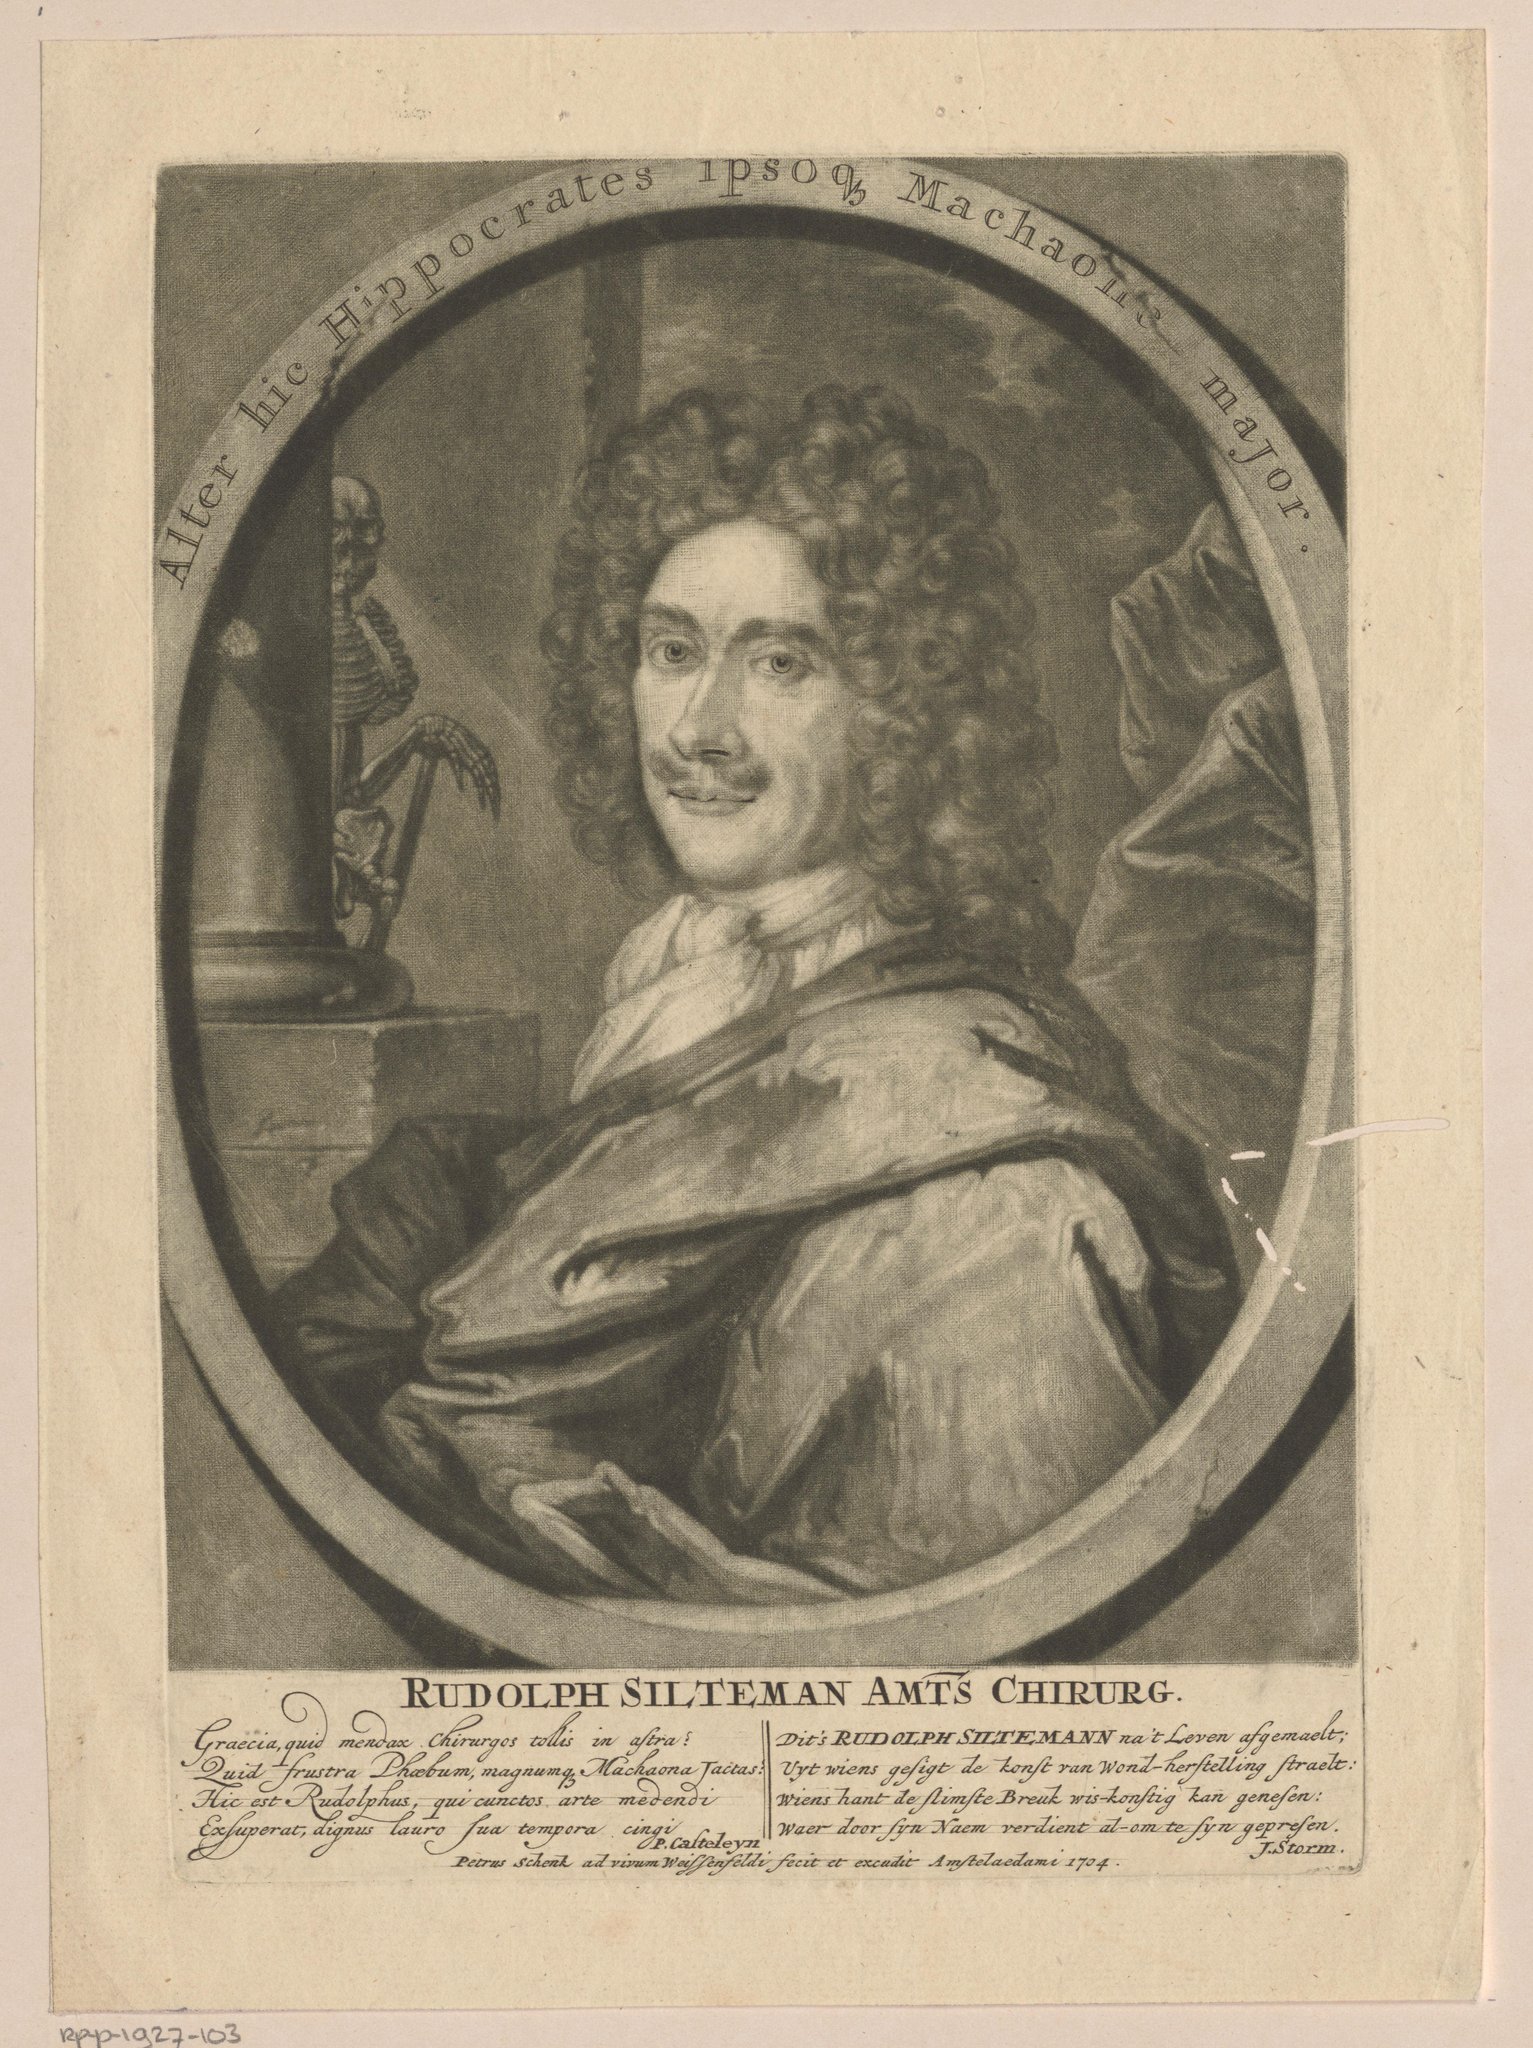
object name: print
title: Portret van Rudolph Silteman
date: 1704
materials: paper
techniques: etching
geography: amsterdam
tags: historical persons, barber; surgeon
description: Met achtregelig onderschrift in twee kolommen in het Latijn en het Nederlands.